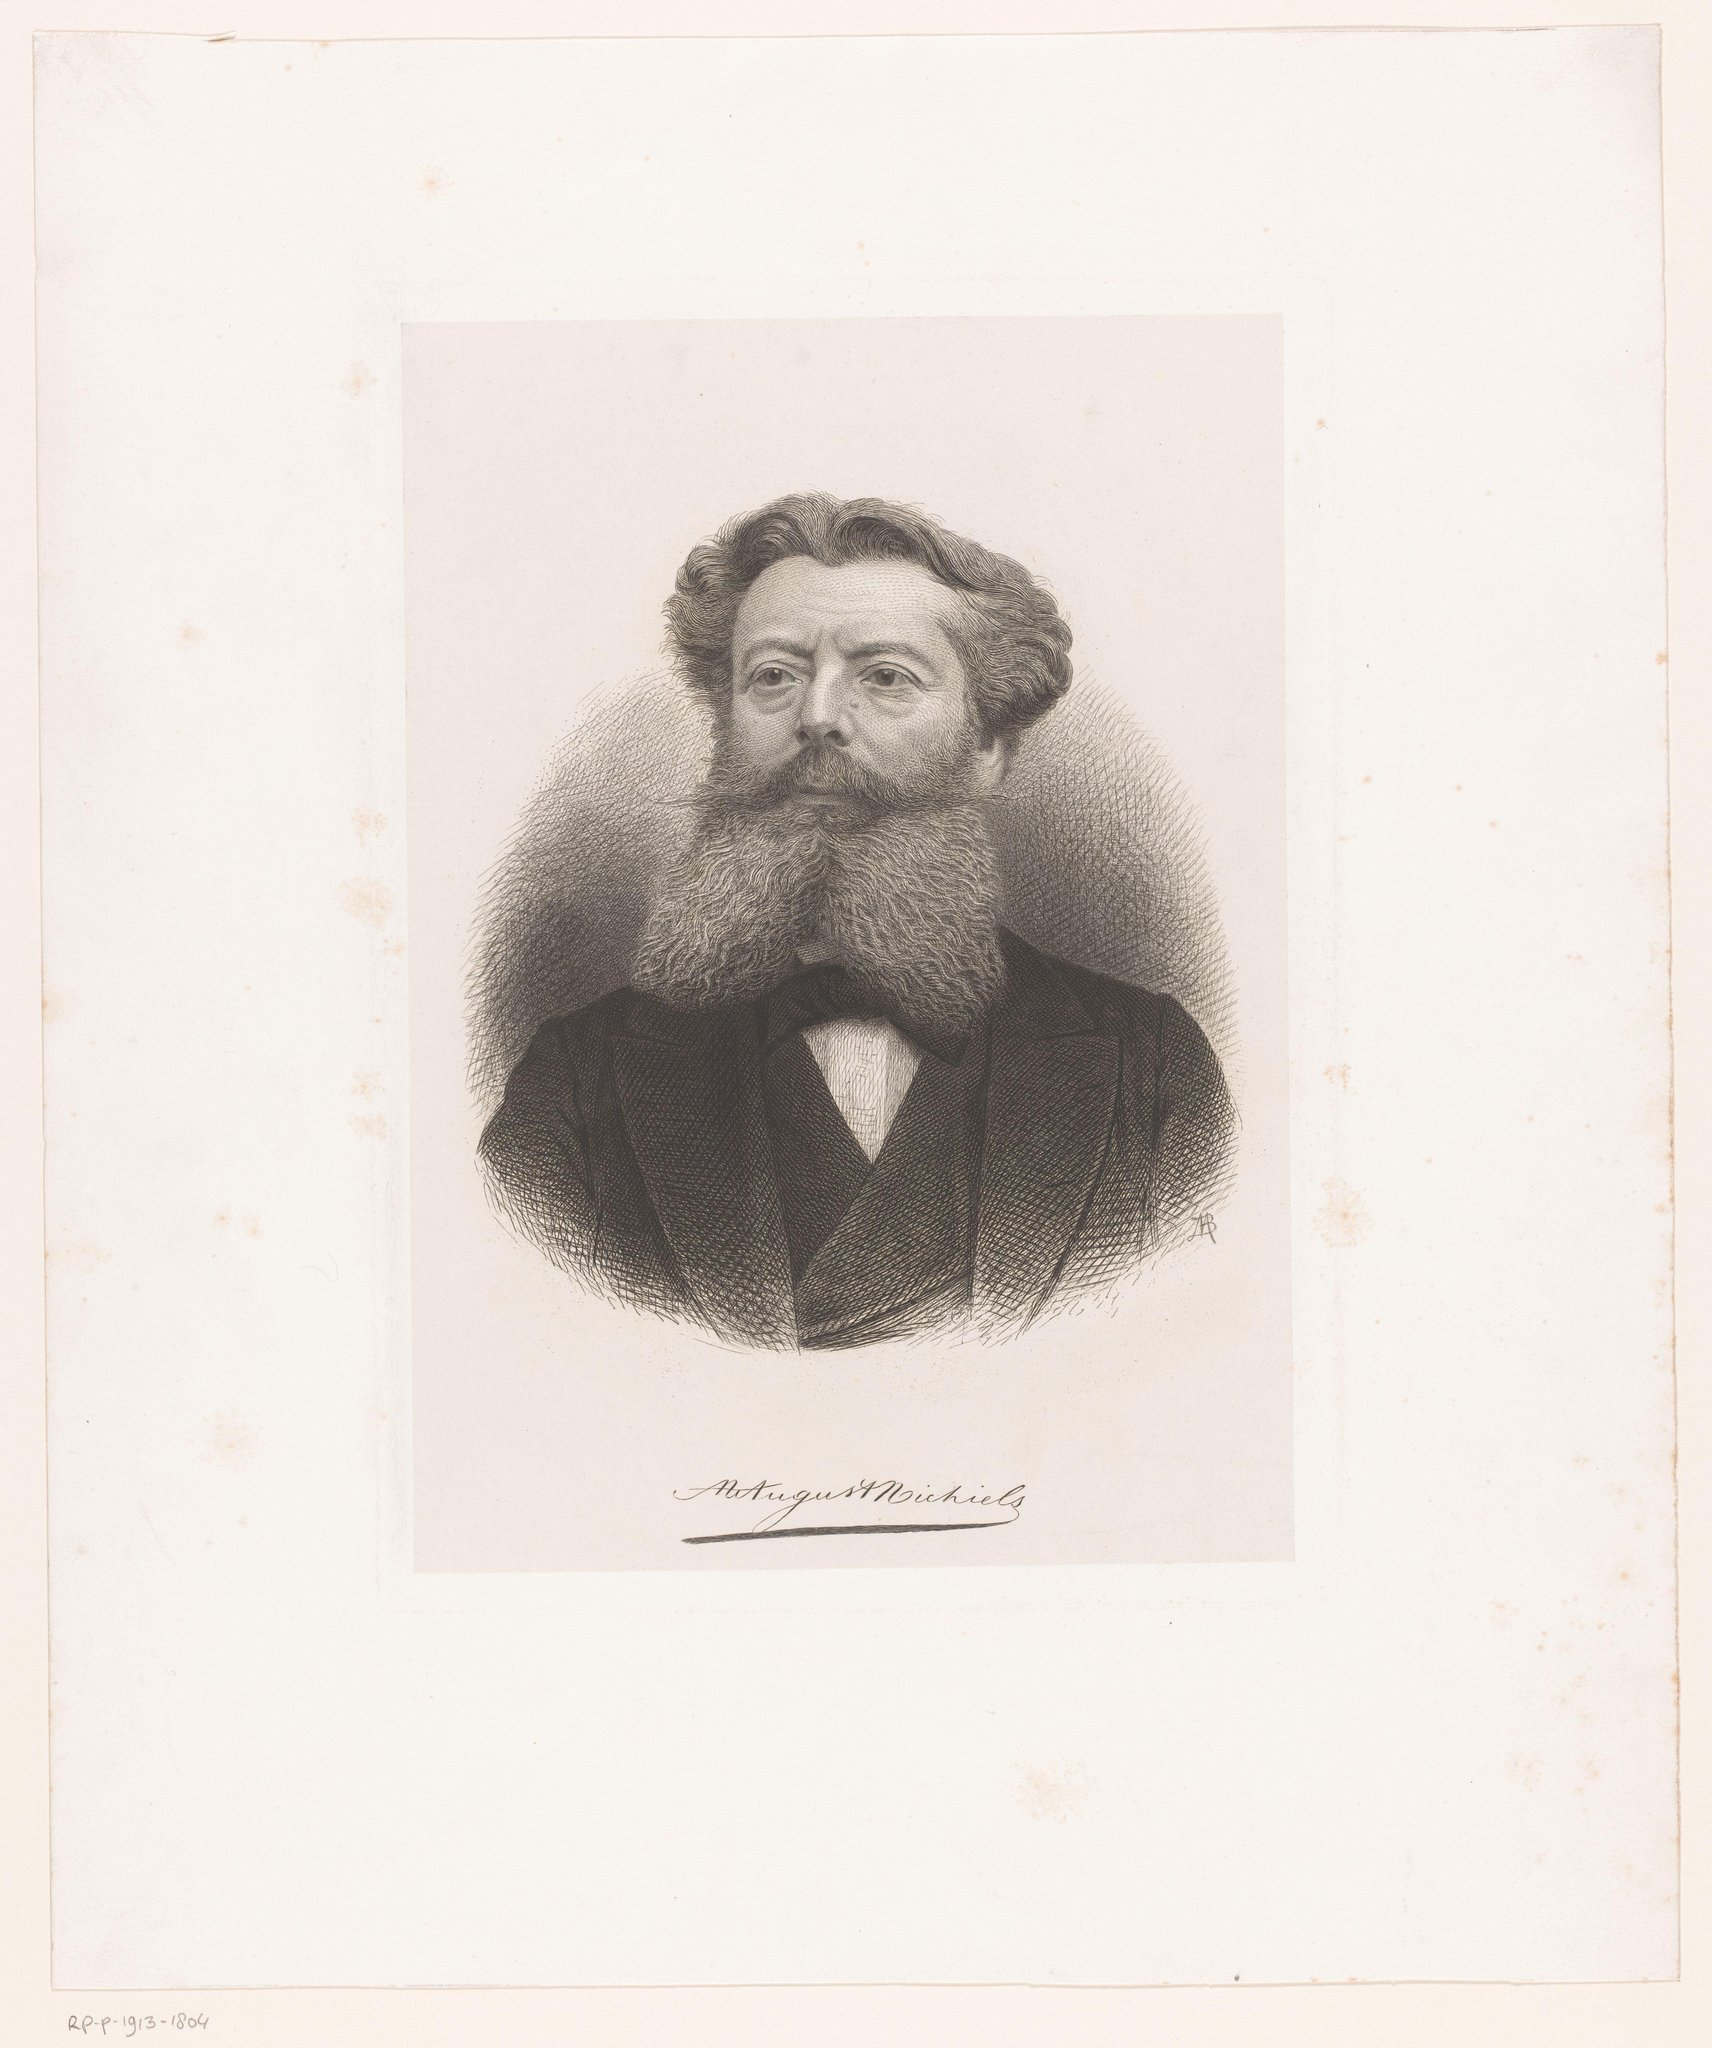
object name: print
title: Mr August Michiels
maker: jean baptiste pierre michiels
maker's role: print maker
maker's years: 1821-1890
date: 1831-1890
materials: paper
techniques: etching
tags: adult man, historical persons, beard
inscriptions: collector's mark: Lugt 2228